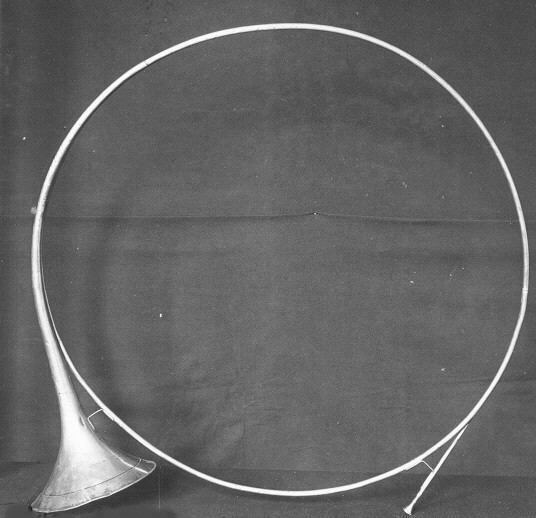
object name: trompe à la dampierre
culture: french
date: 1710-1730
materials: brass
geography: france